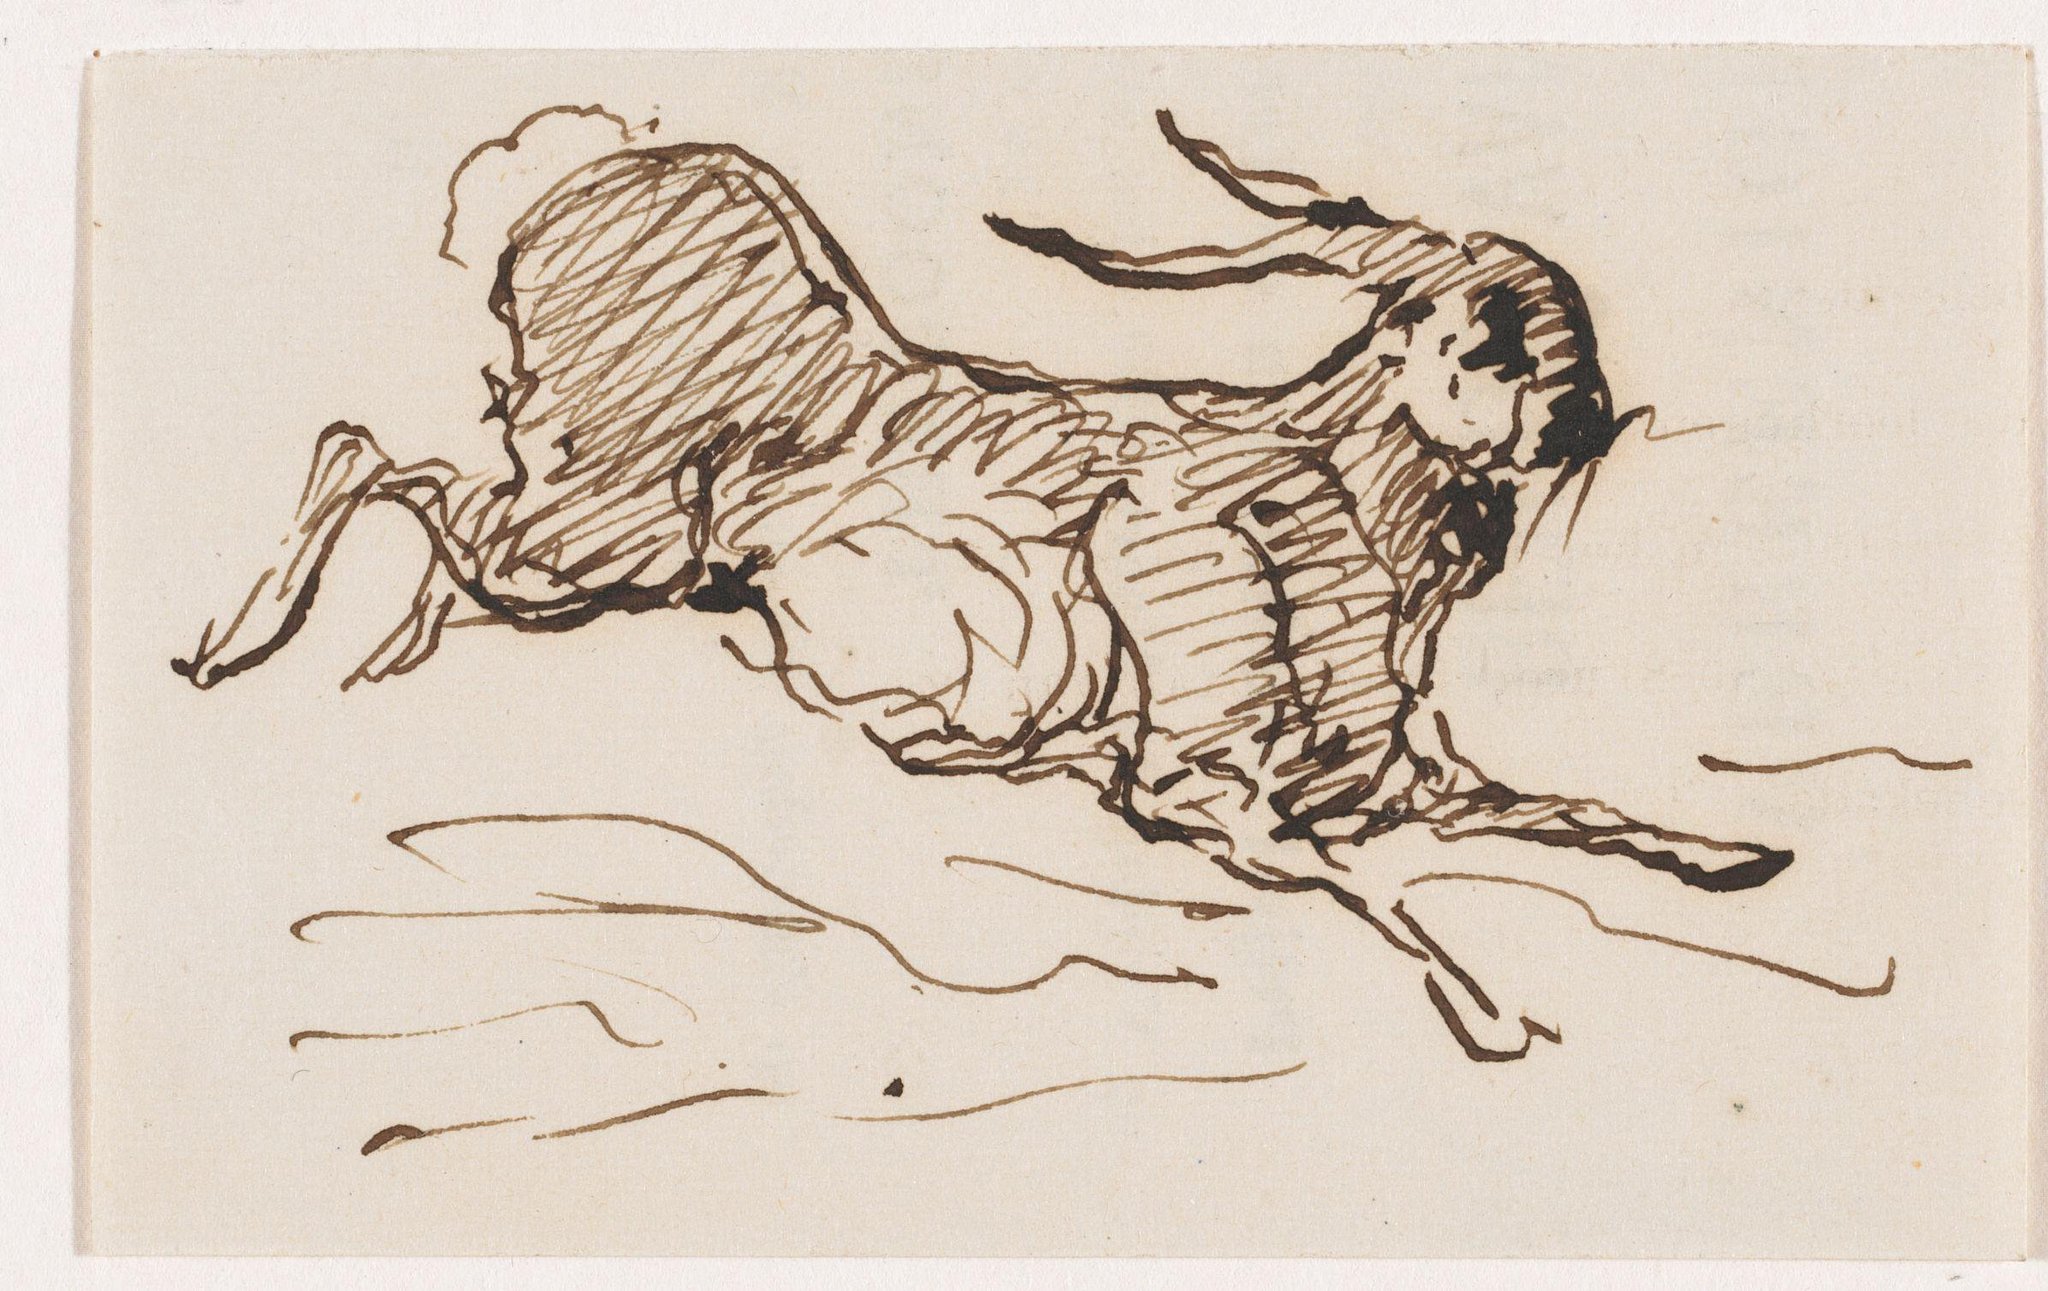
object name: drawing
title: Haas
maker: johannes tavenraat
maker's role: draughtsman, painter, print maker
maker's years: 1809-1881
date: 1869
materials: ink, paper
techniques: pen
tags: rodents: hare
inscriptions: collector's mark: Lugt 2228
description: Haas. Getekend op de achterzijde van een fragment van een drukwerk met de datum 19 maart 1869.